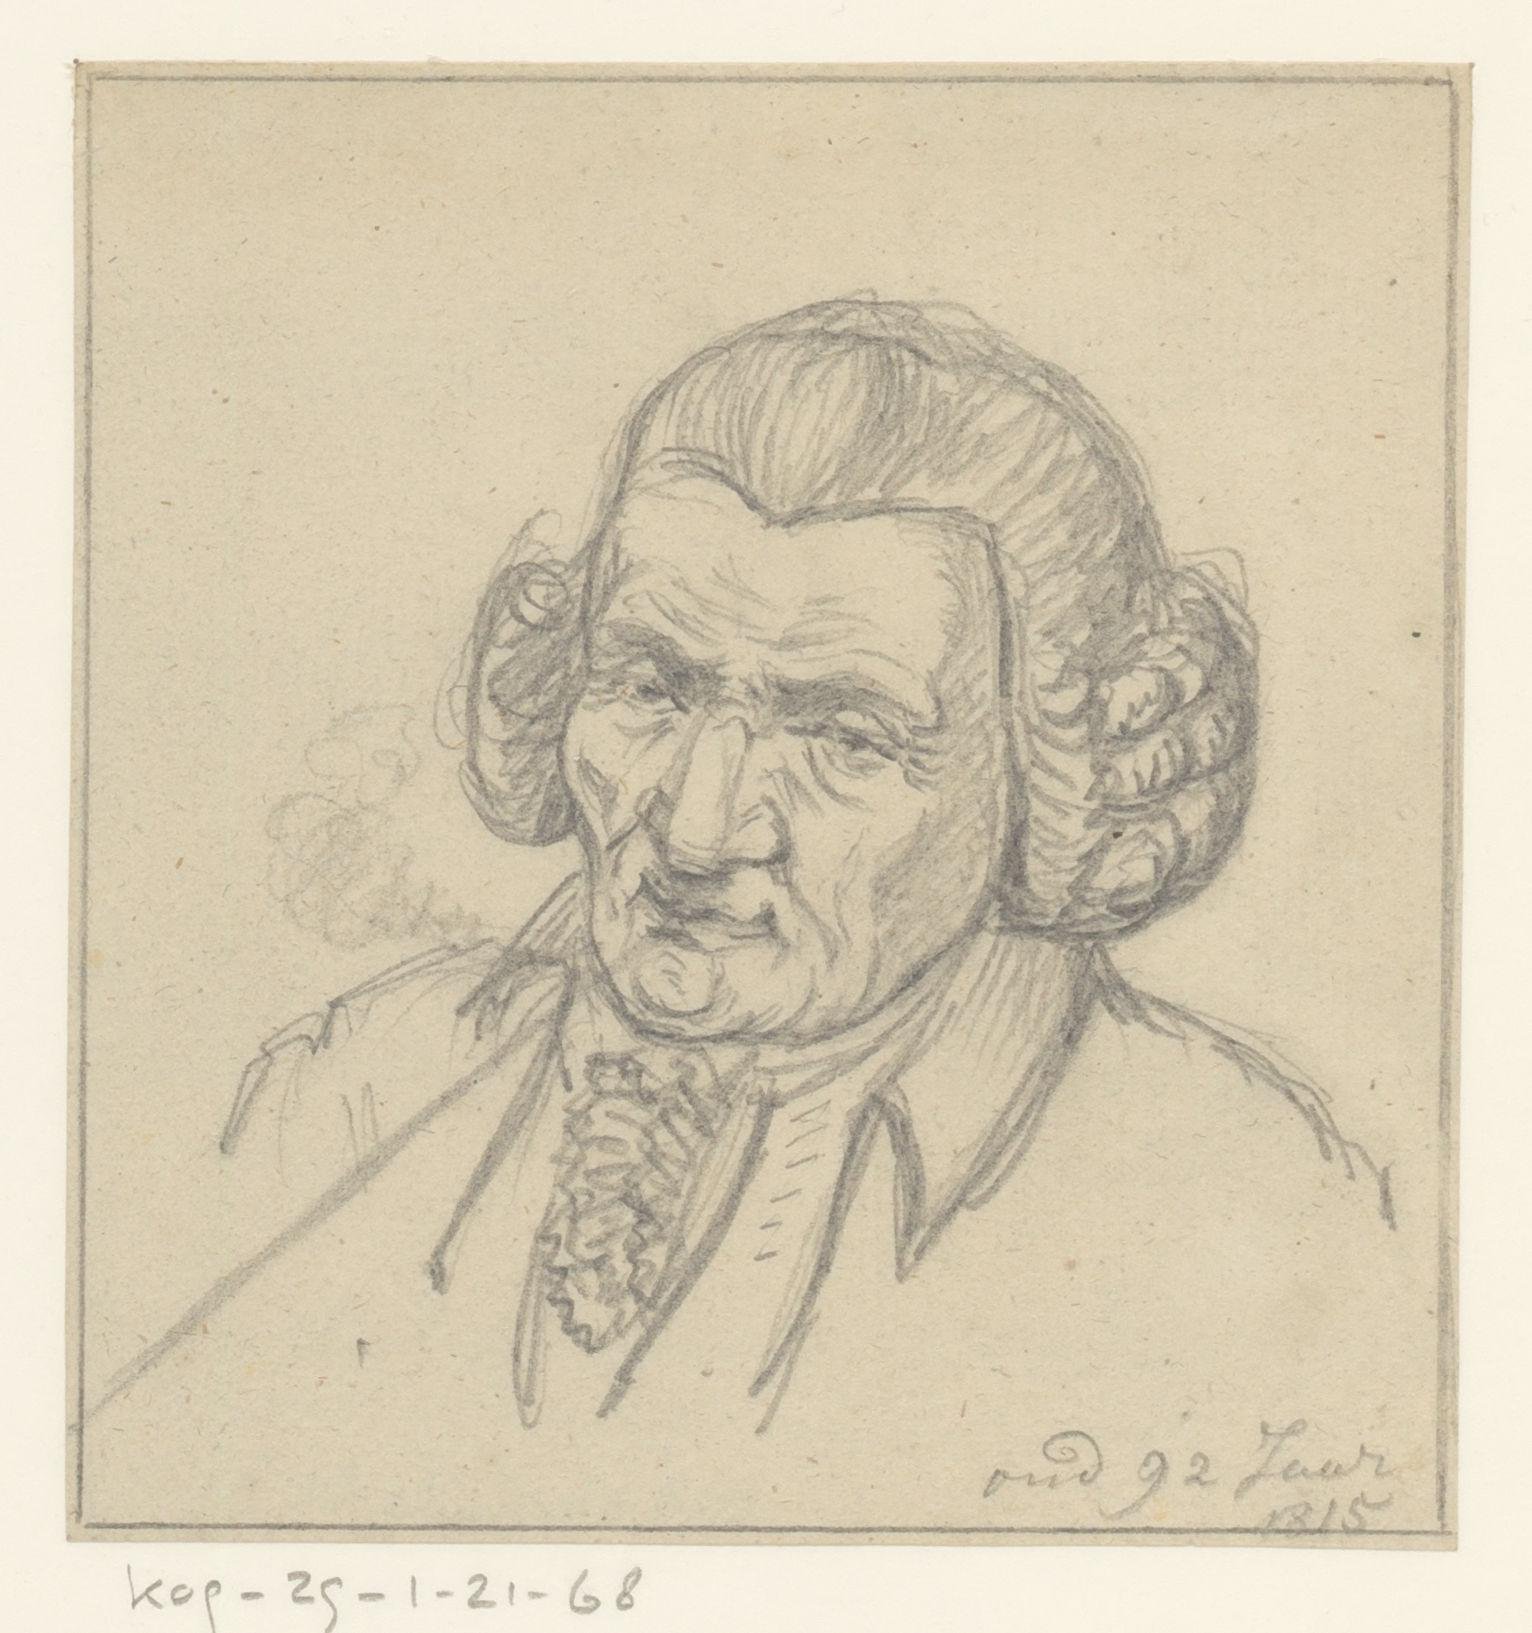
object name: drawing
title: Oude man, op 92-jarige leeftijd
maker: jean bernard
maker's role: draughtsman, print maker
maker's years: 1765-1833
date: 1815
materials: paper, pencil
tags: old man, wig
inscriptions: collector's mark: Lugt 1641, stamp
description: Onderwerpsrubrieken binnen de Atlas Zeden en Gewoonten: Zeden en Gewoonten in Engeren Zin, De Kleeding, Kleederdrachten (tijdvakken), De 18de eeuw (de pruikentijd). Mannen en vrouwen.